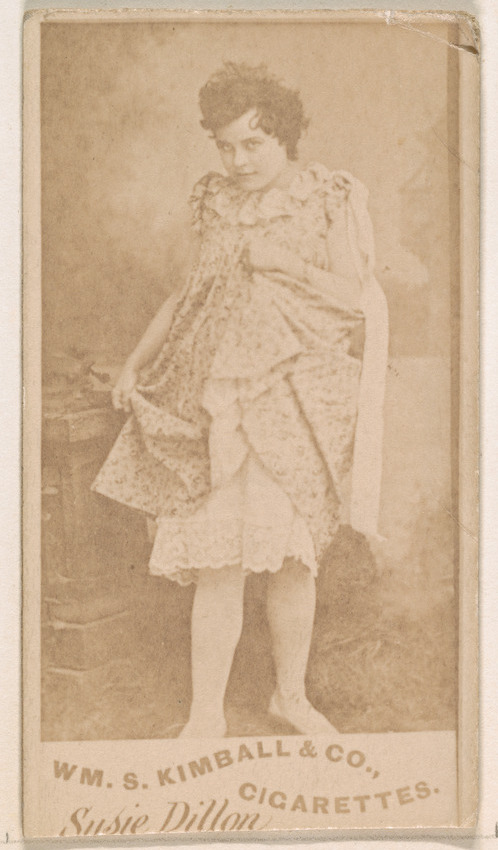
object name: photograph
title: Susie Dillon, from the Actresses series (N203) issued by Wm. S. Kimball & Co.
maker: william s. kimball & company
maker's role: publisher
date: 1889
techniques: color lithograph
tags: portraits,women,actresses